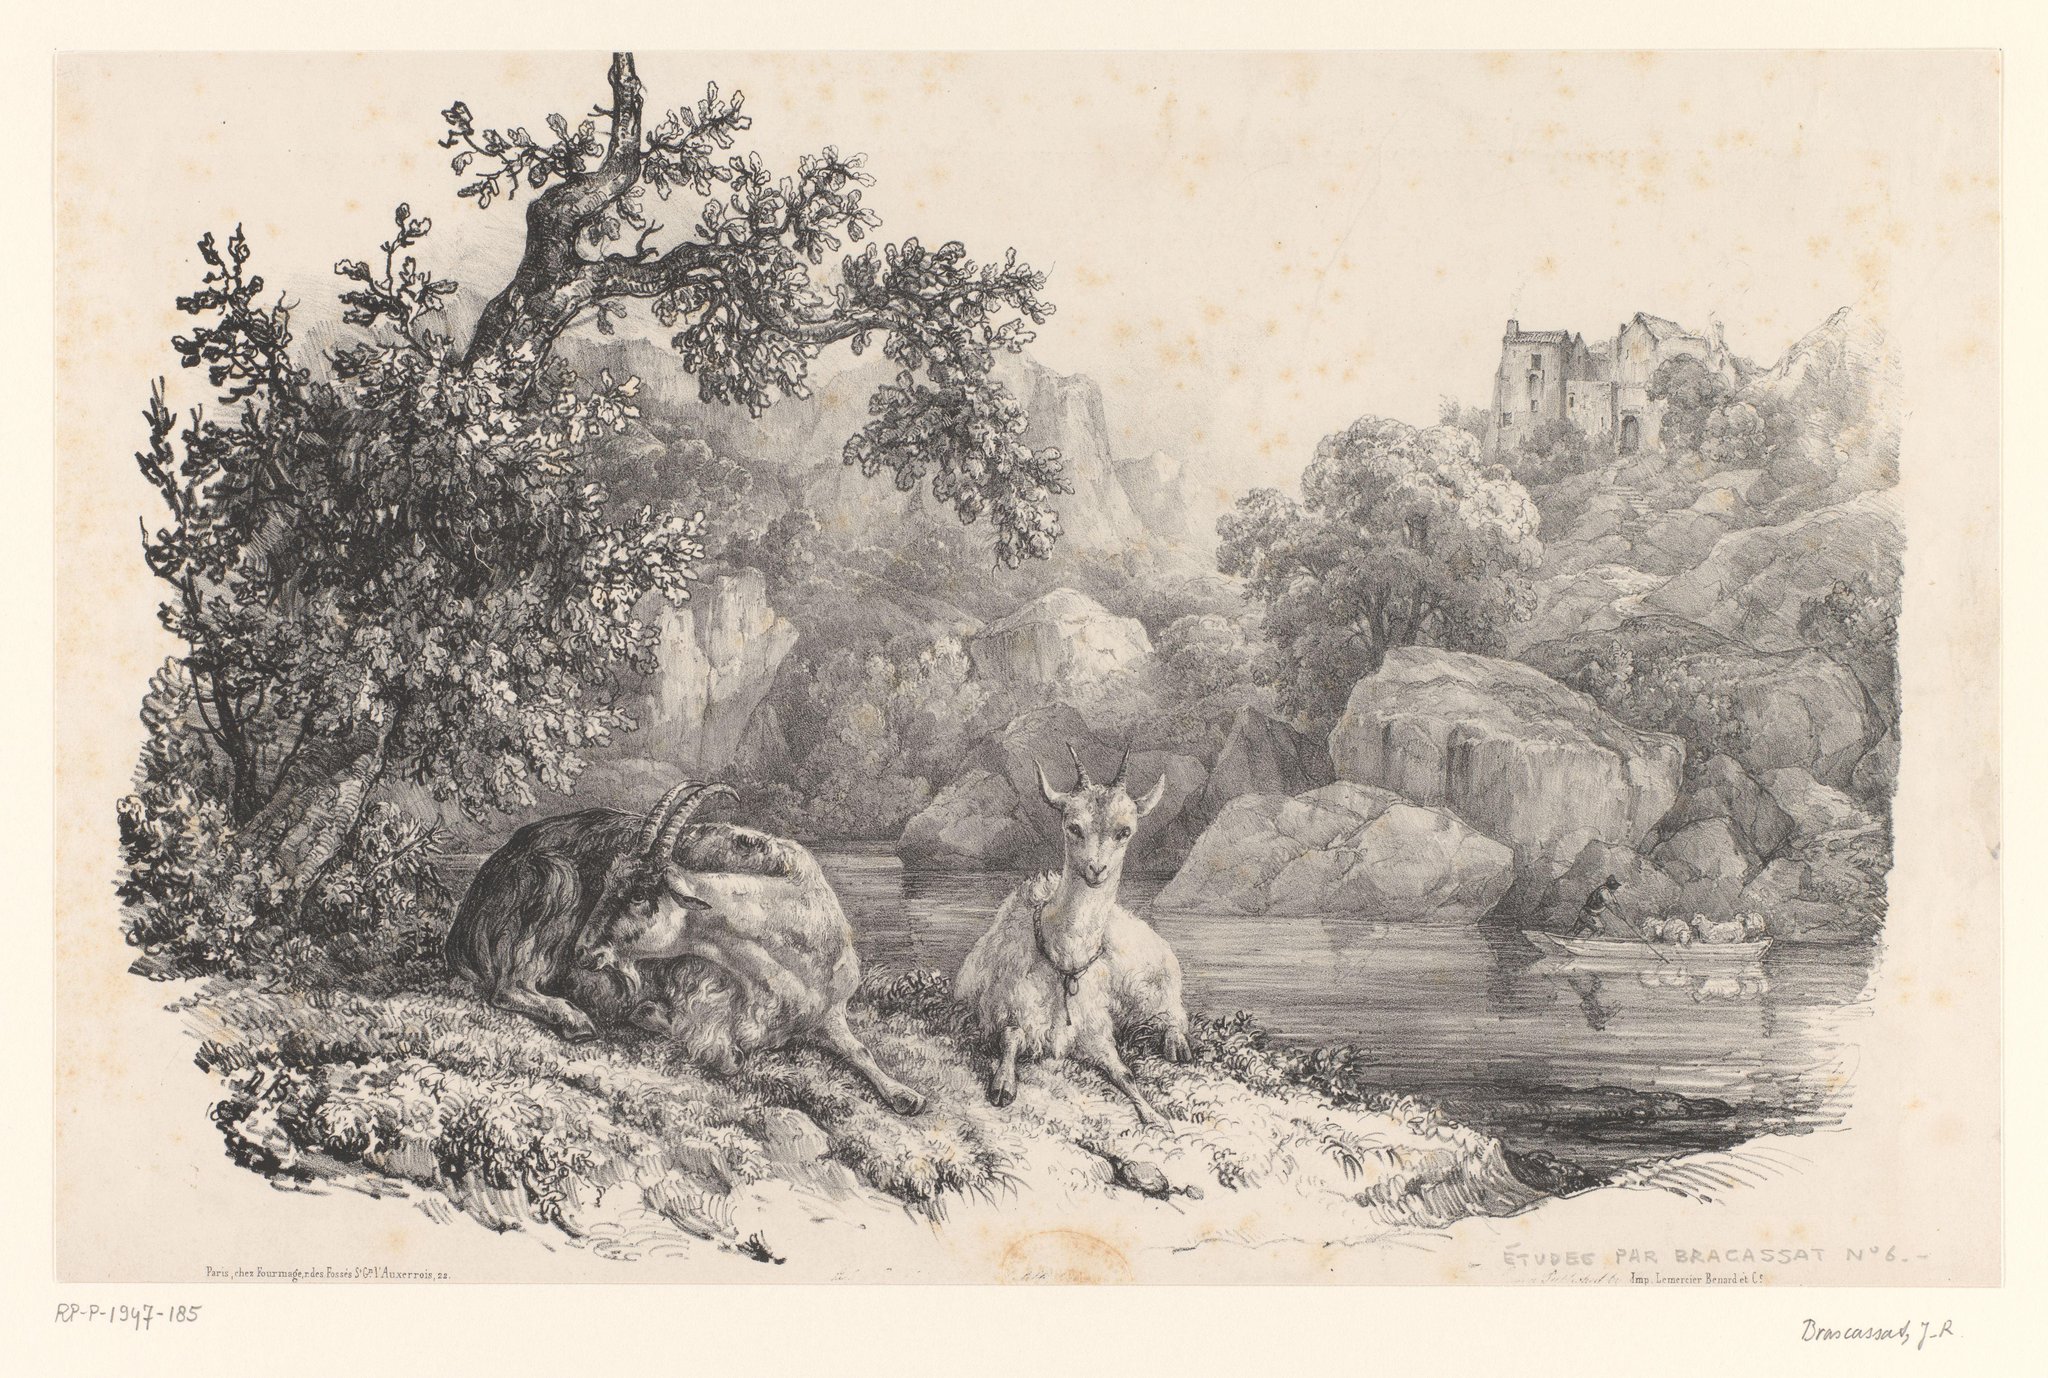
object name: print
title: Twee rustende geiten in een landschap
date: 1831-1860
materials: paper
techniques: lithograph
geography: paris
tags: landscape with tower or castle, goat, rocks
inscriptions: check stamp: Lugt 5285, collector's mark: Lugt 2228a